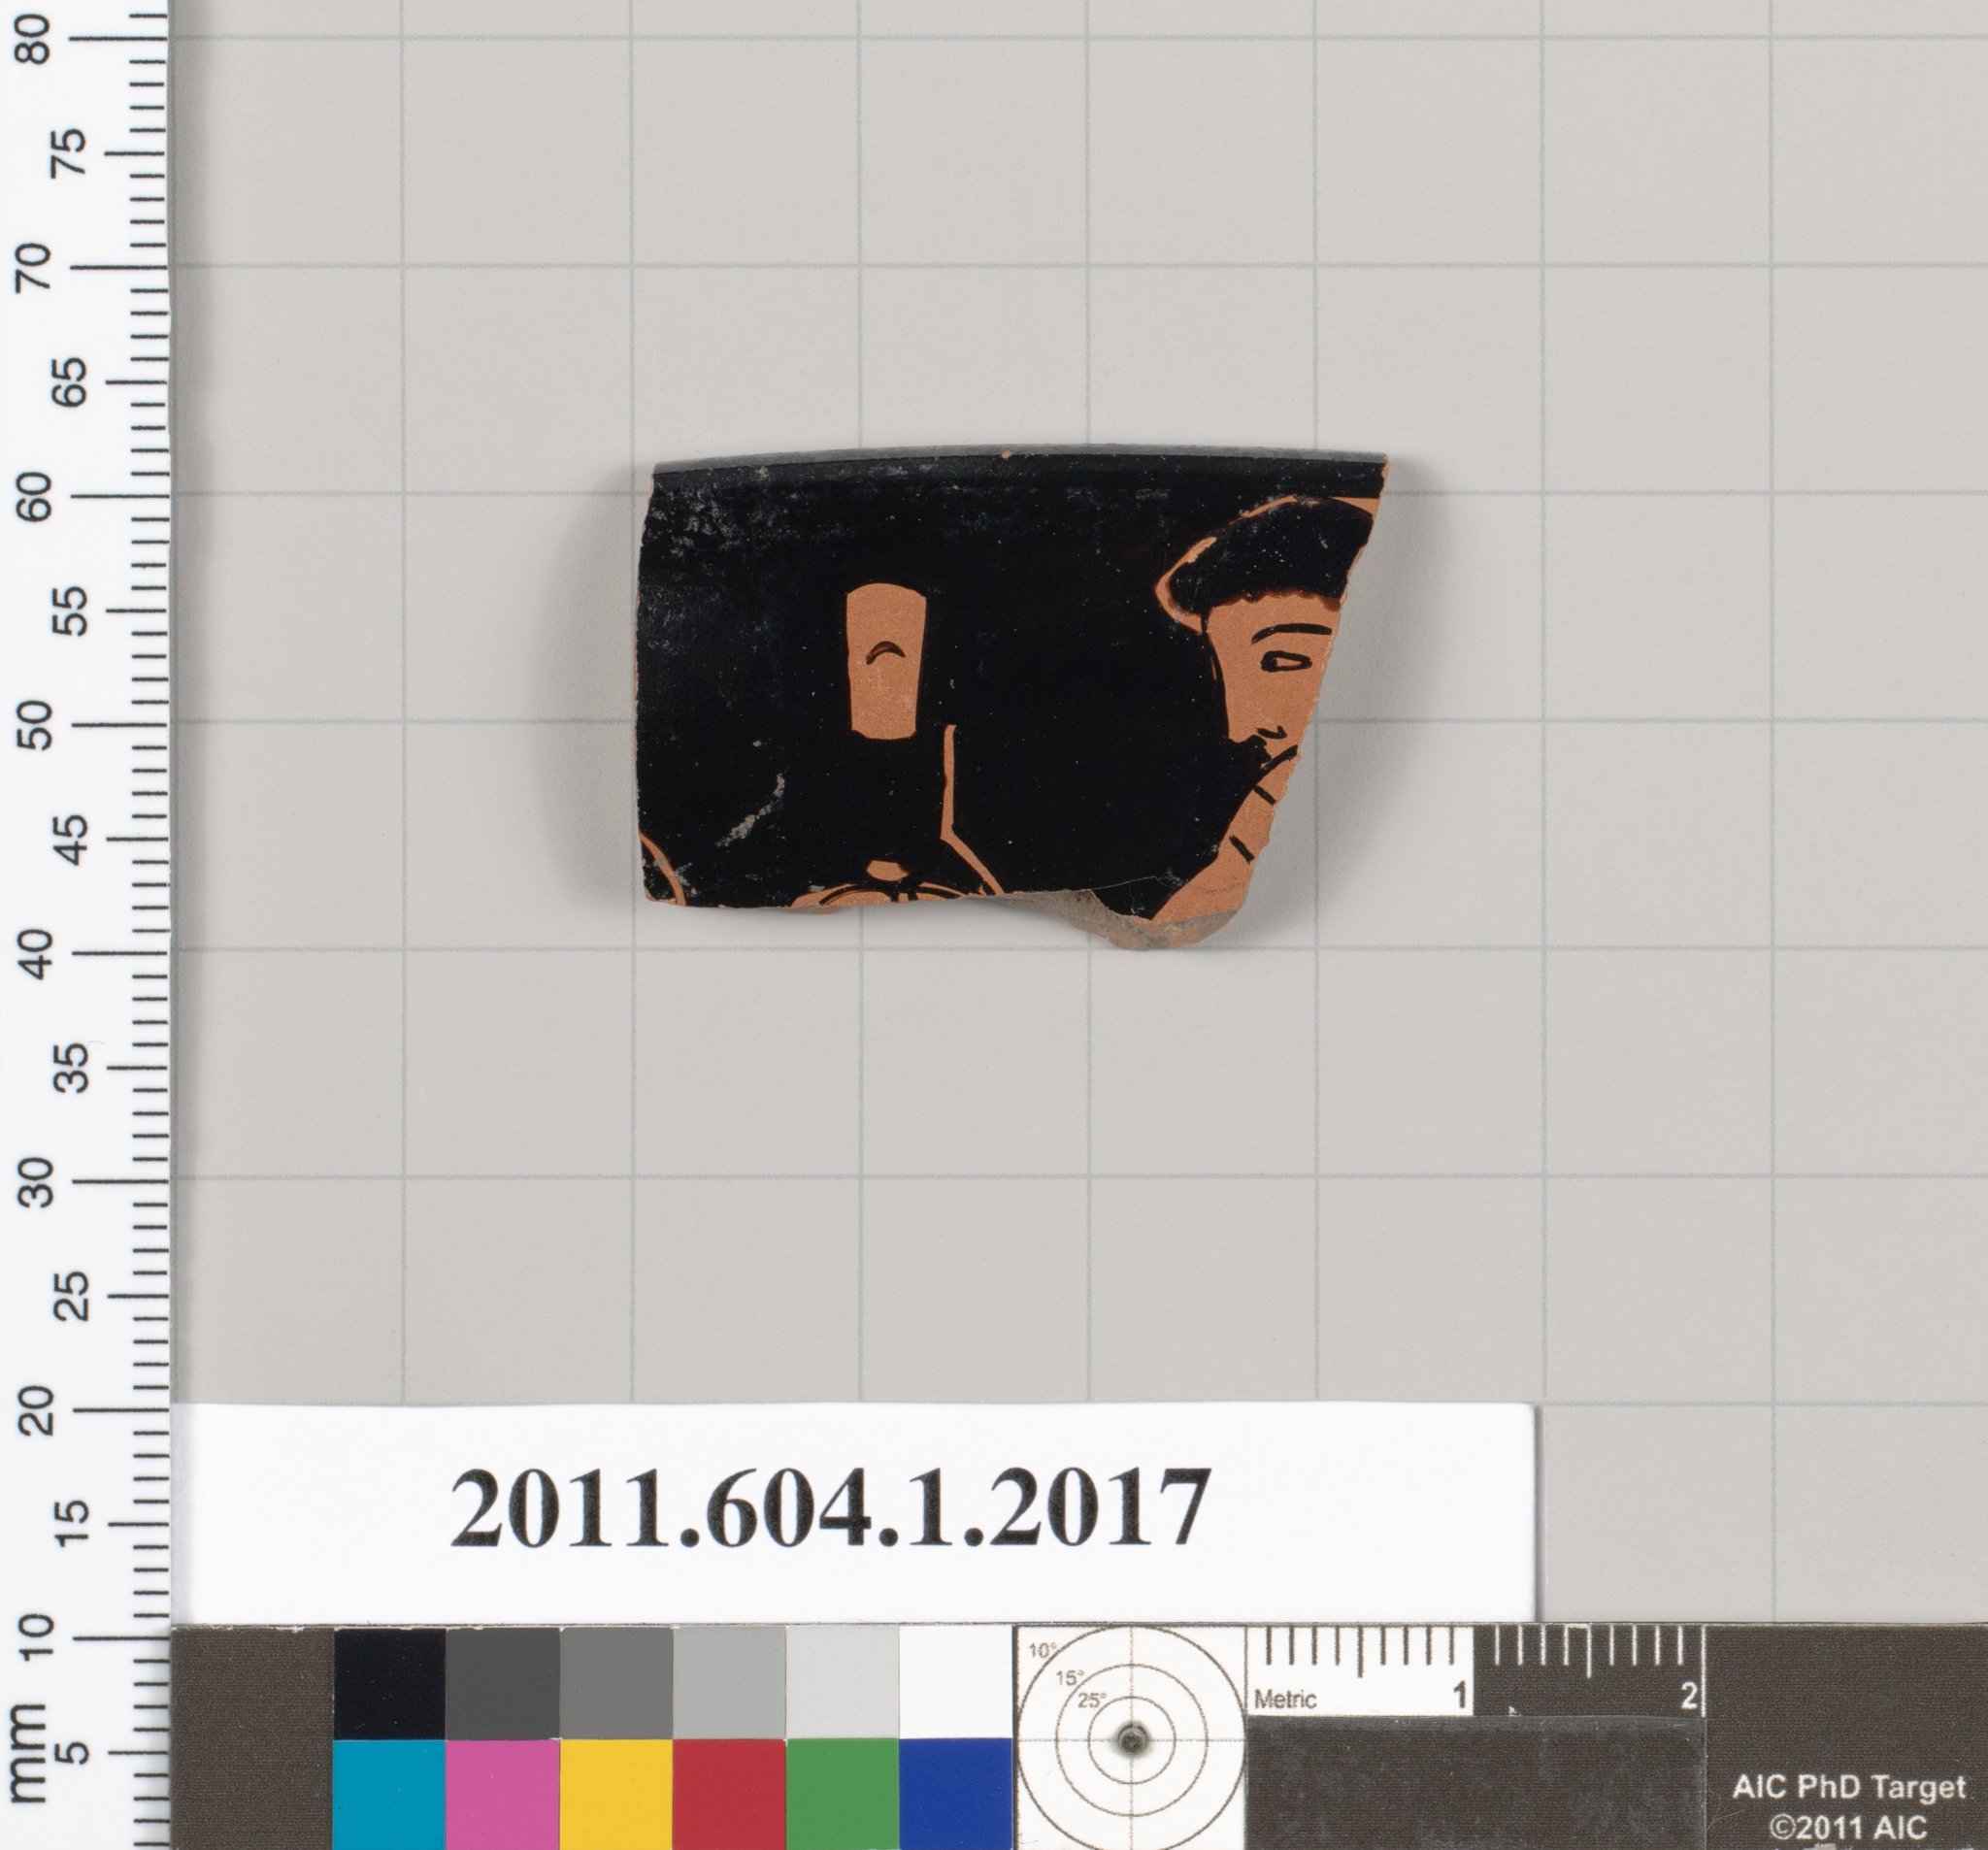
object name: kylix fragment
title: Terracotta rim fragment of a kylix (drinking cup)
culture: greek, attic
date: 475-451 BCE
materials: terracotta